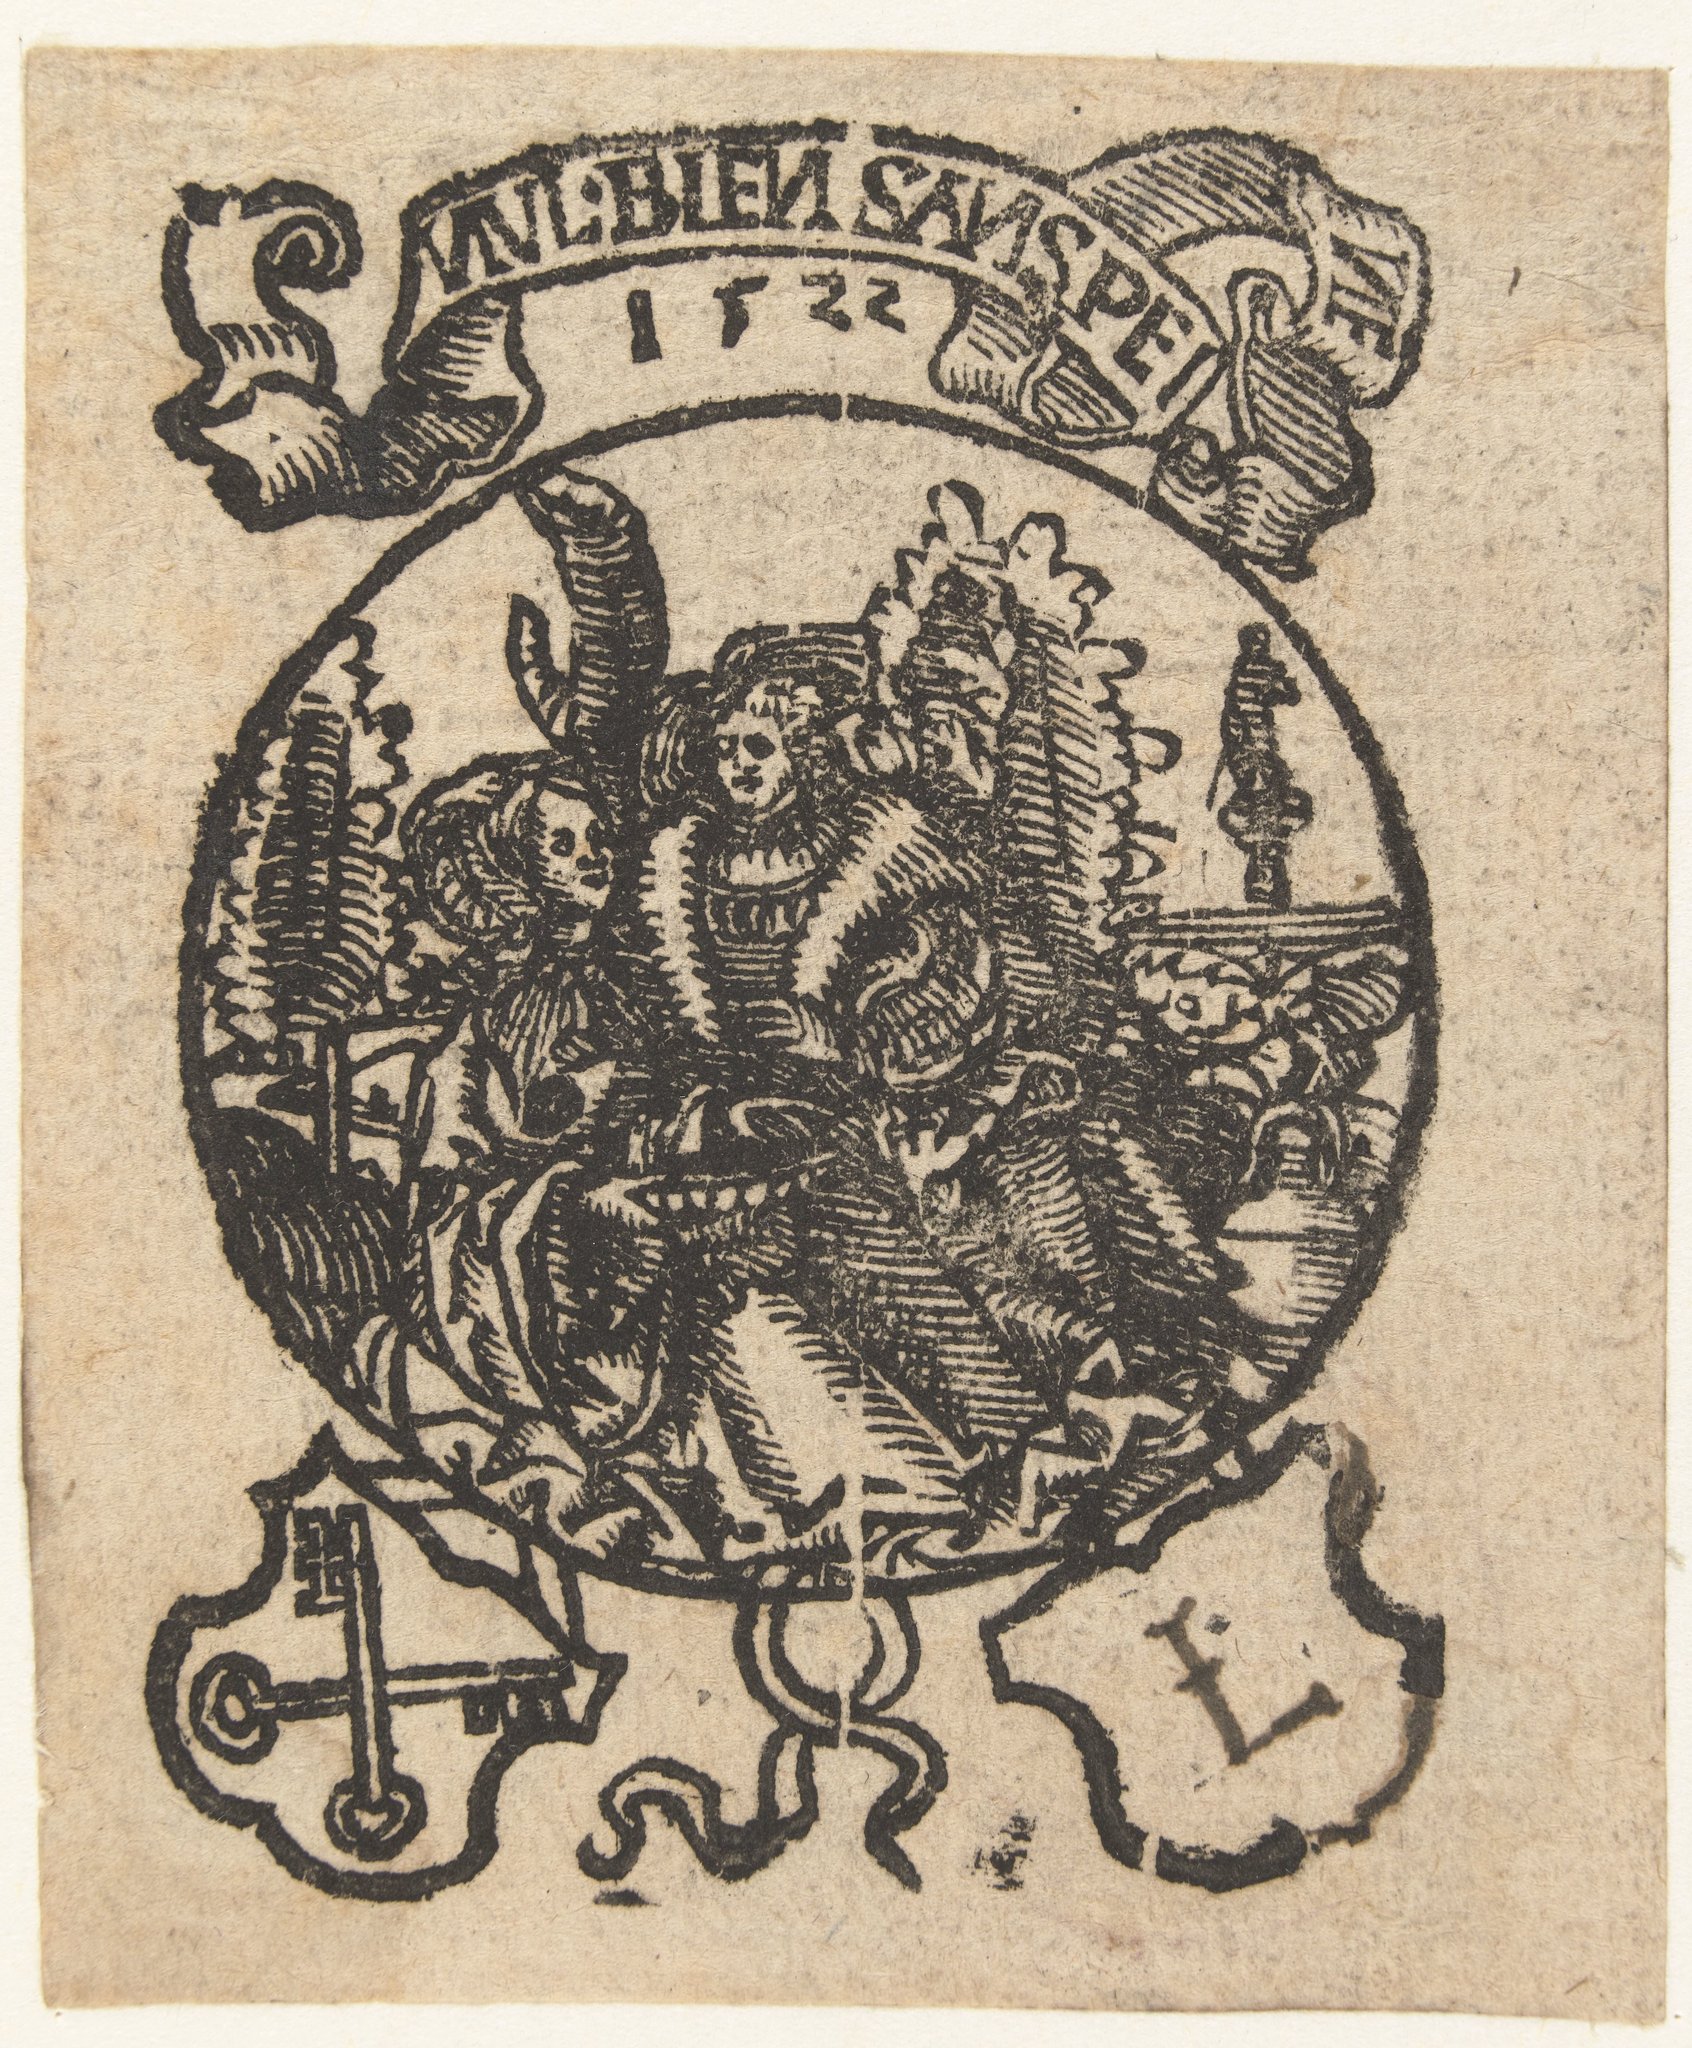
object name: print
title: Liefdespaar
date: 1522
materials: paper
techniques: woodcut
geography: leiden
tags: coat of arms (as symbol of the state, etc.), couple of lovers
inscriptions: collector's mark: Lugt 240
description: Cirkel met voorstelling van liefdespaar in tuin. Boven cirkel cartouche met spreekwoord. Onder de cirkel twee wapenschilden, één met het wapen van Leiden en één met een L, geschreven met pen.